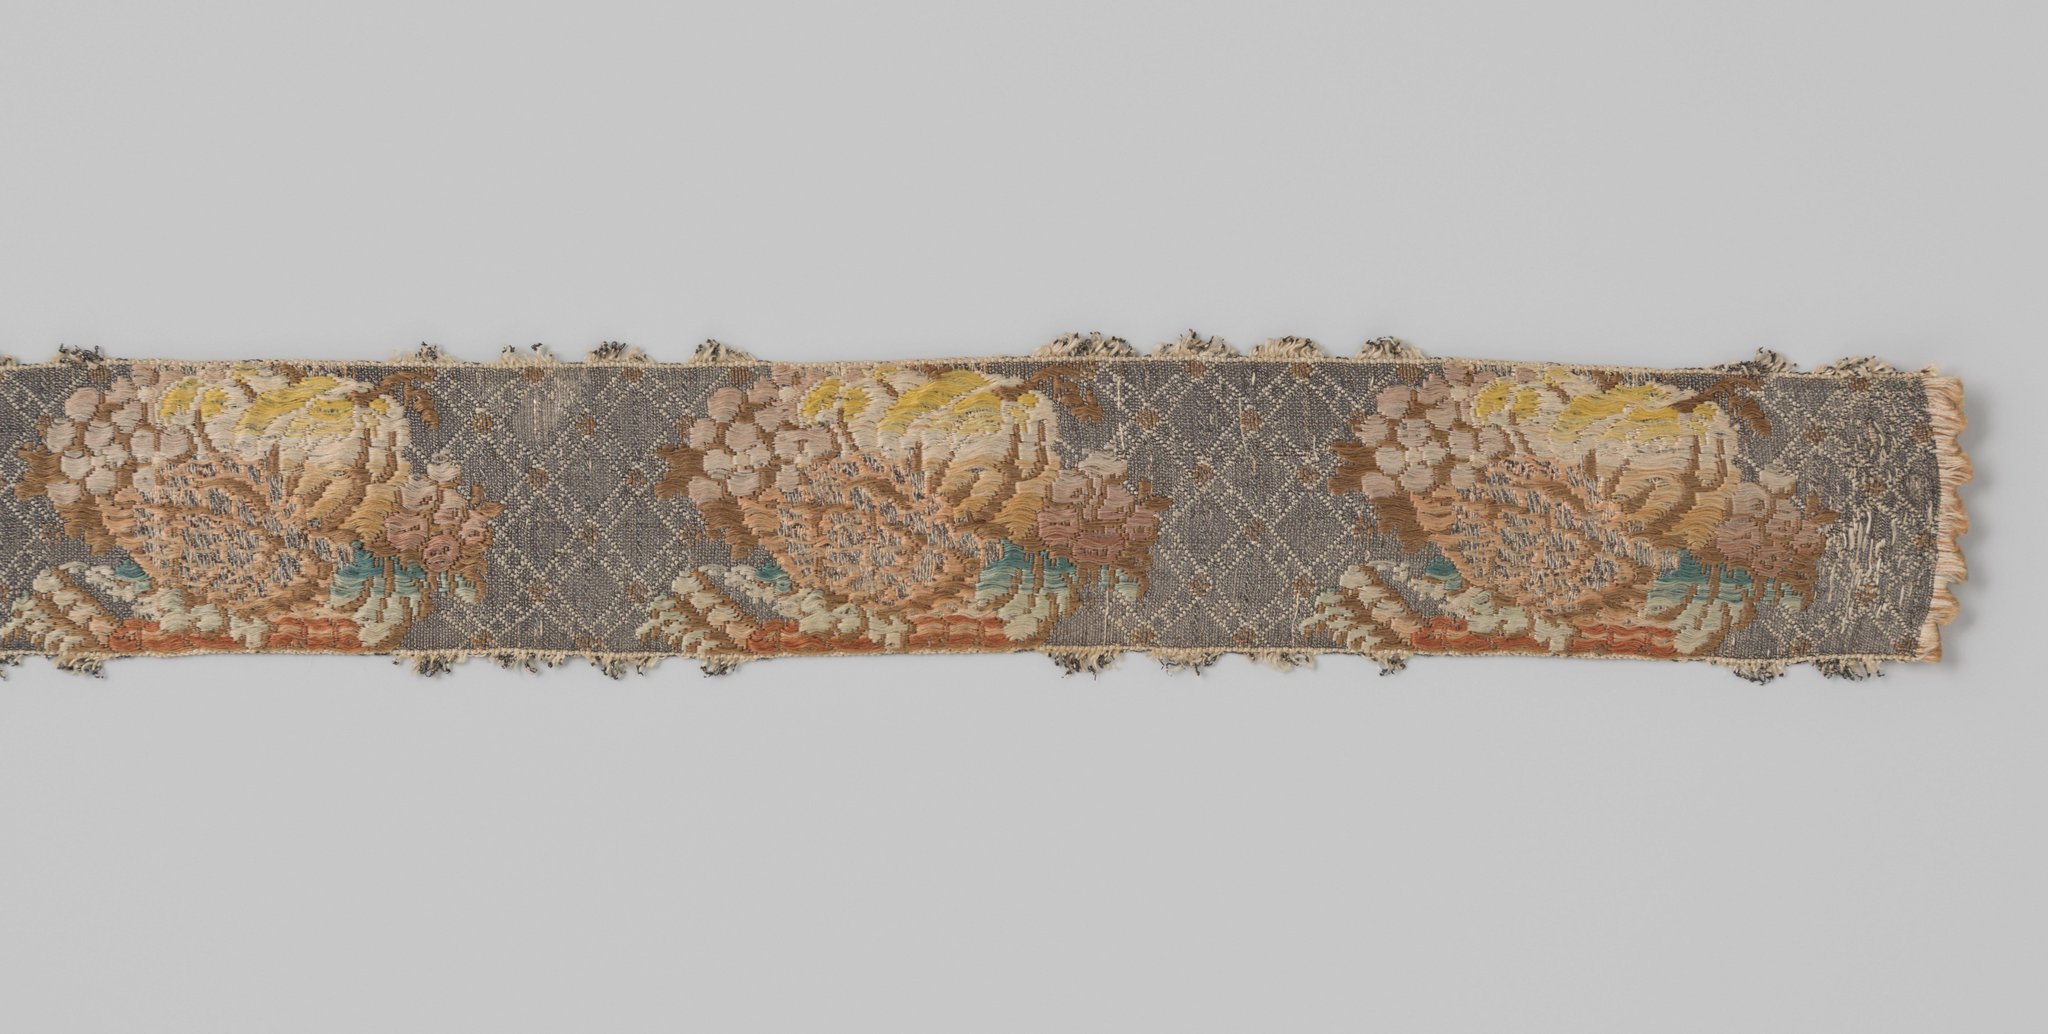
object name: clothing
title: Lint van zijdebrokaat; op een zilverkleurige achtergrond met ruitpatroon is een zich herhalen patroon van een gekleurd boeket aangebracht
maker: Anonymous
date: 1700-1725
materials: silk, thread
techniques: brocade, weave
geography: western europe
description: Lint van zijdebrokaat; op een zilverkleurige achtergrond met ruitpatroon is een zich herhalen patroon van een gekleurd boeket aangebracht. De randen zijn afgezet met sierband.